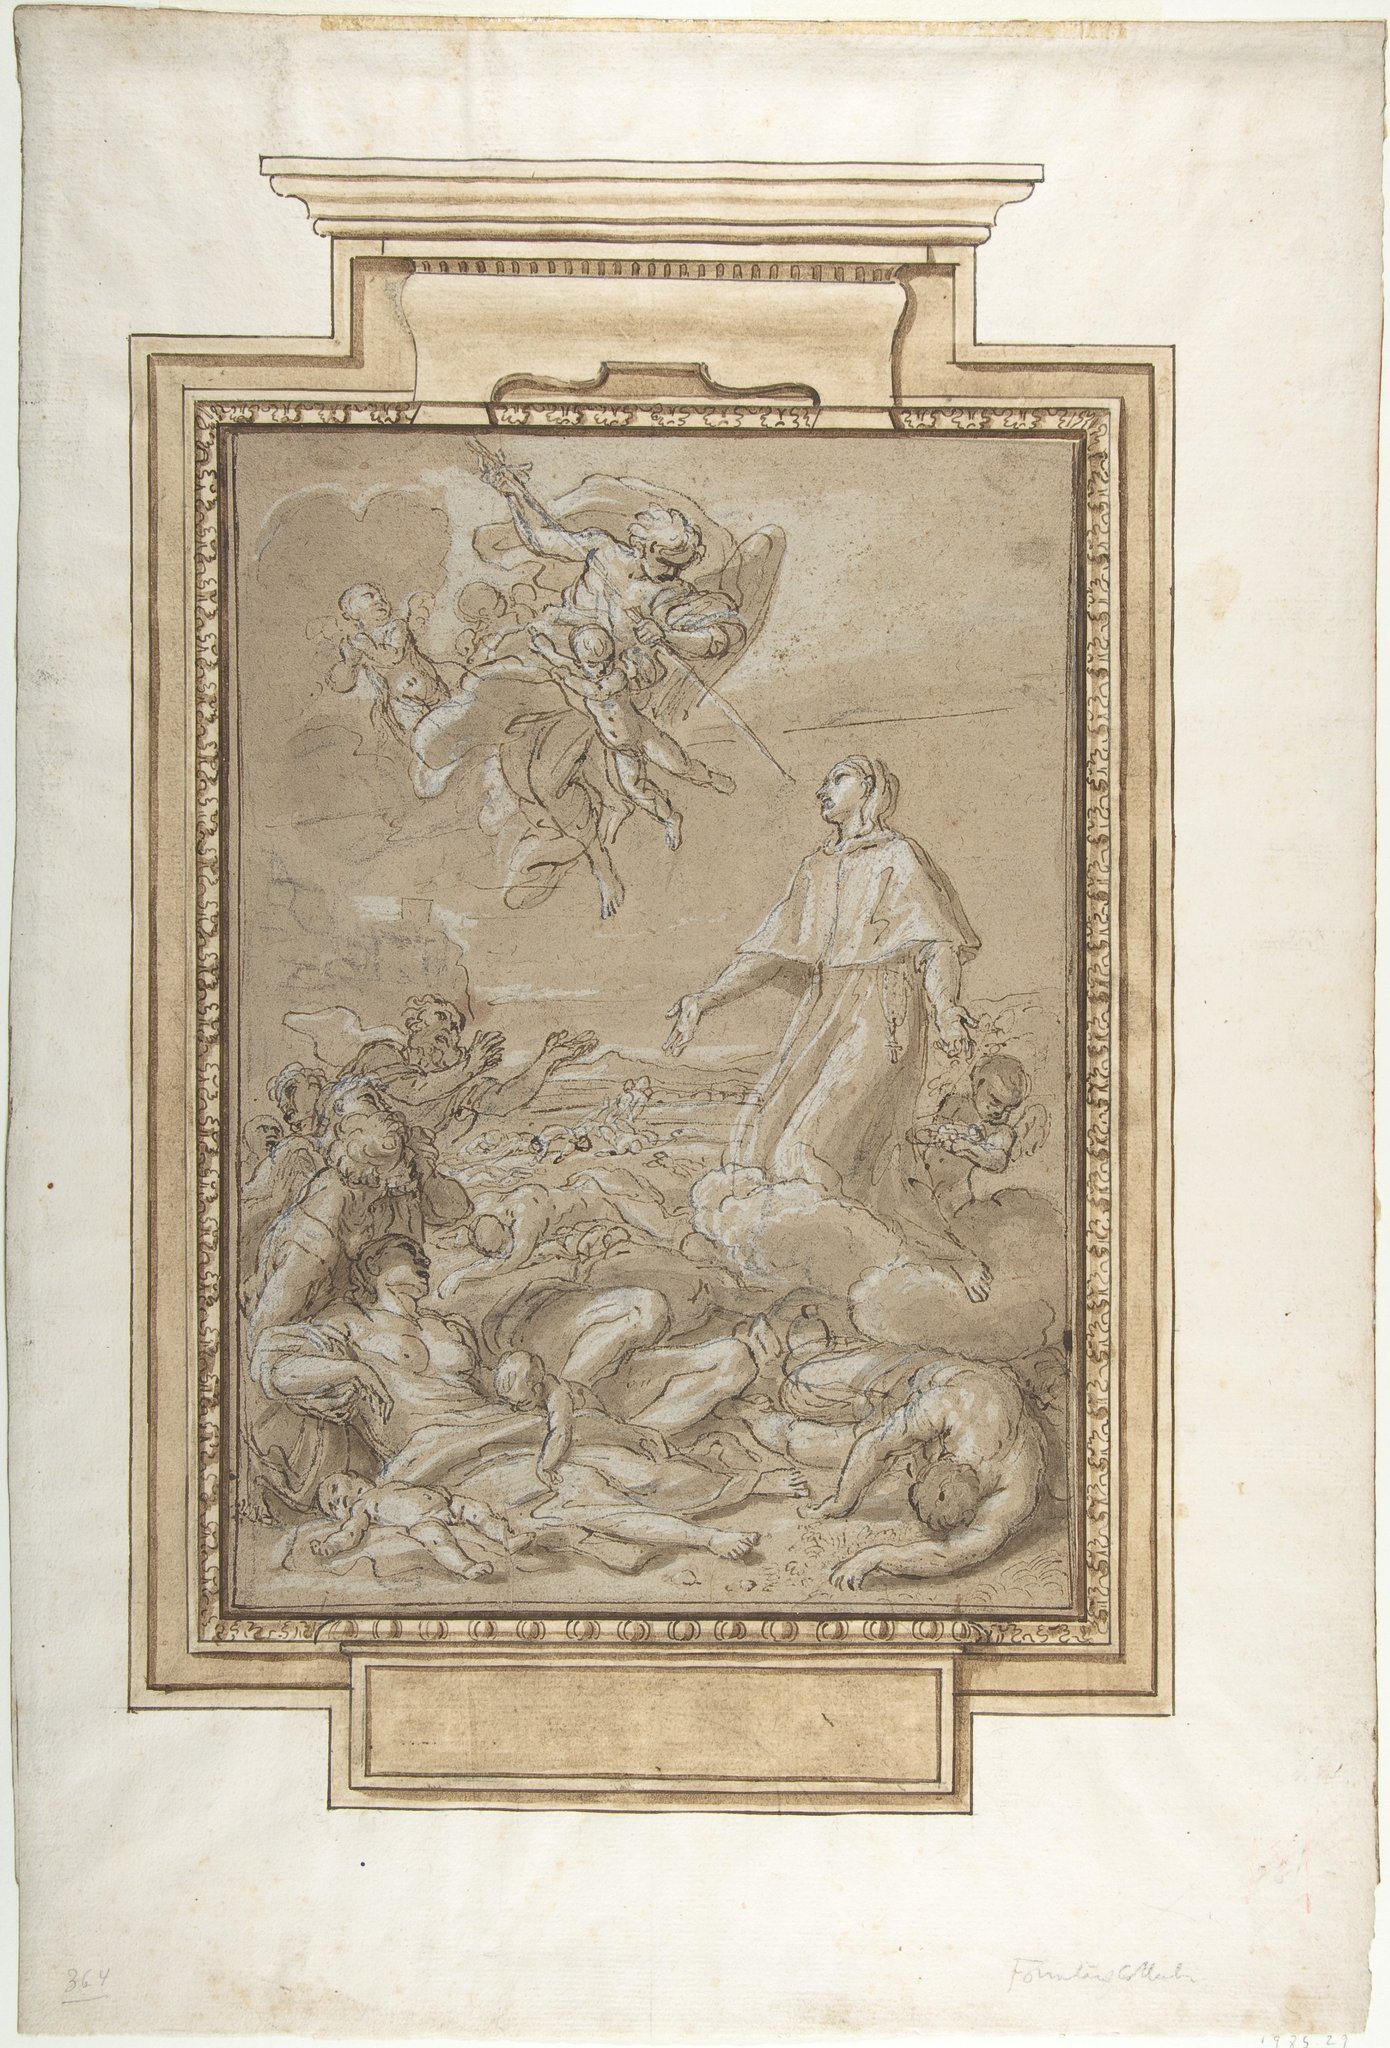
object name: drawing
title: Saint Rosalia Interceding for Victims of the Plague in Palestrina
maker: carlo maratti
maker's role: artist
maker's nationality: italian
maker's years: 1625-1713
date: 1625-1713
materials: chalk, ink, paper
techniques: brush, highlighting, pen, wash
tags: angels,saints